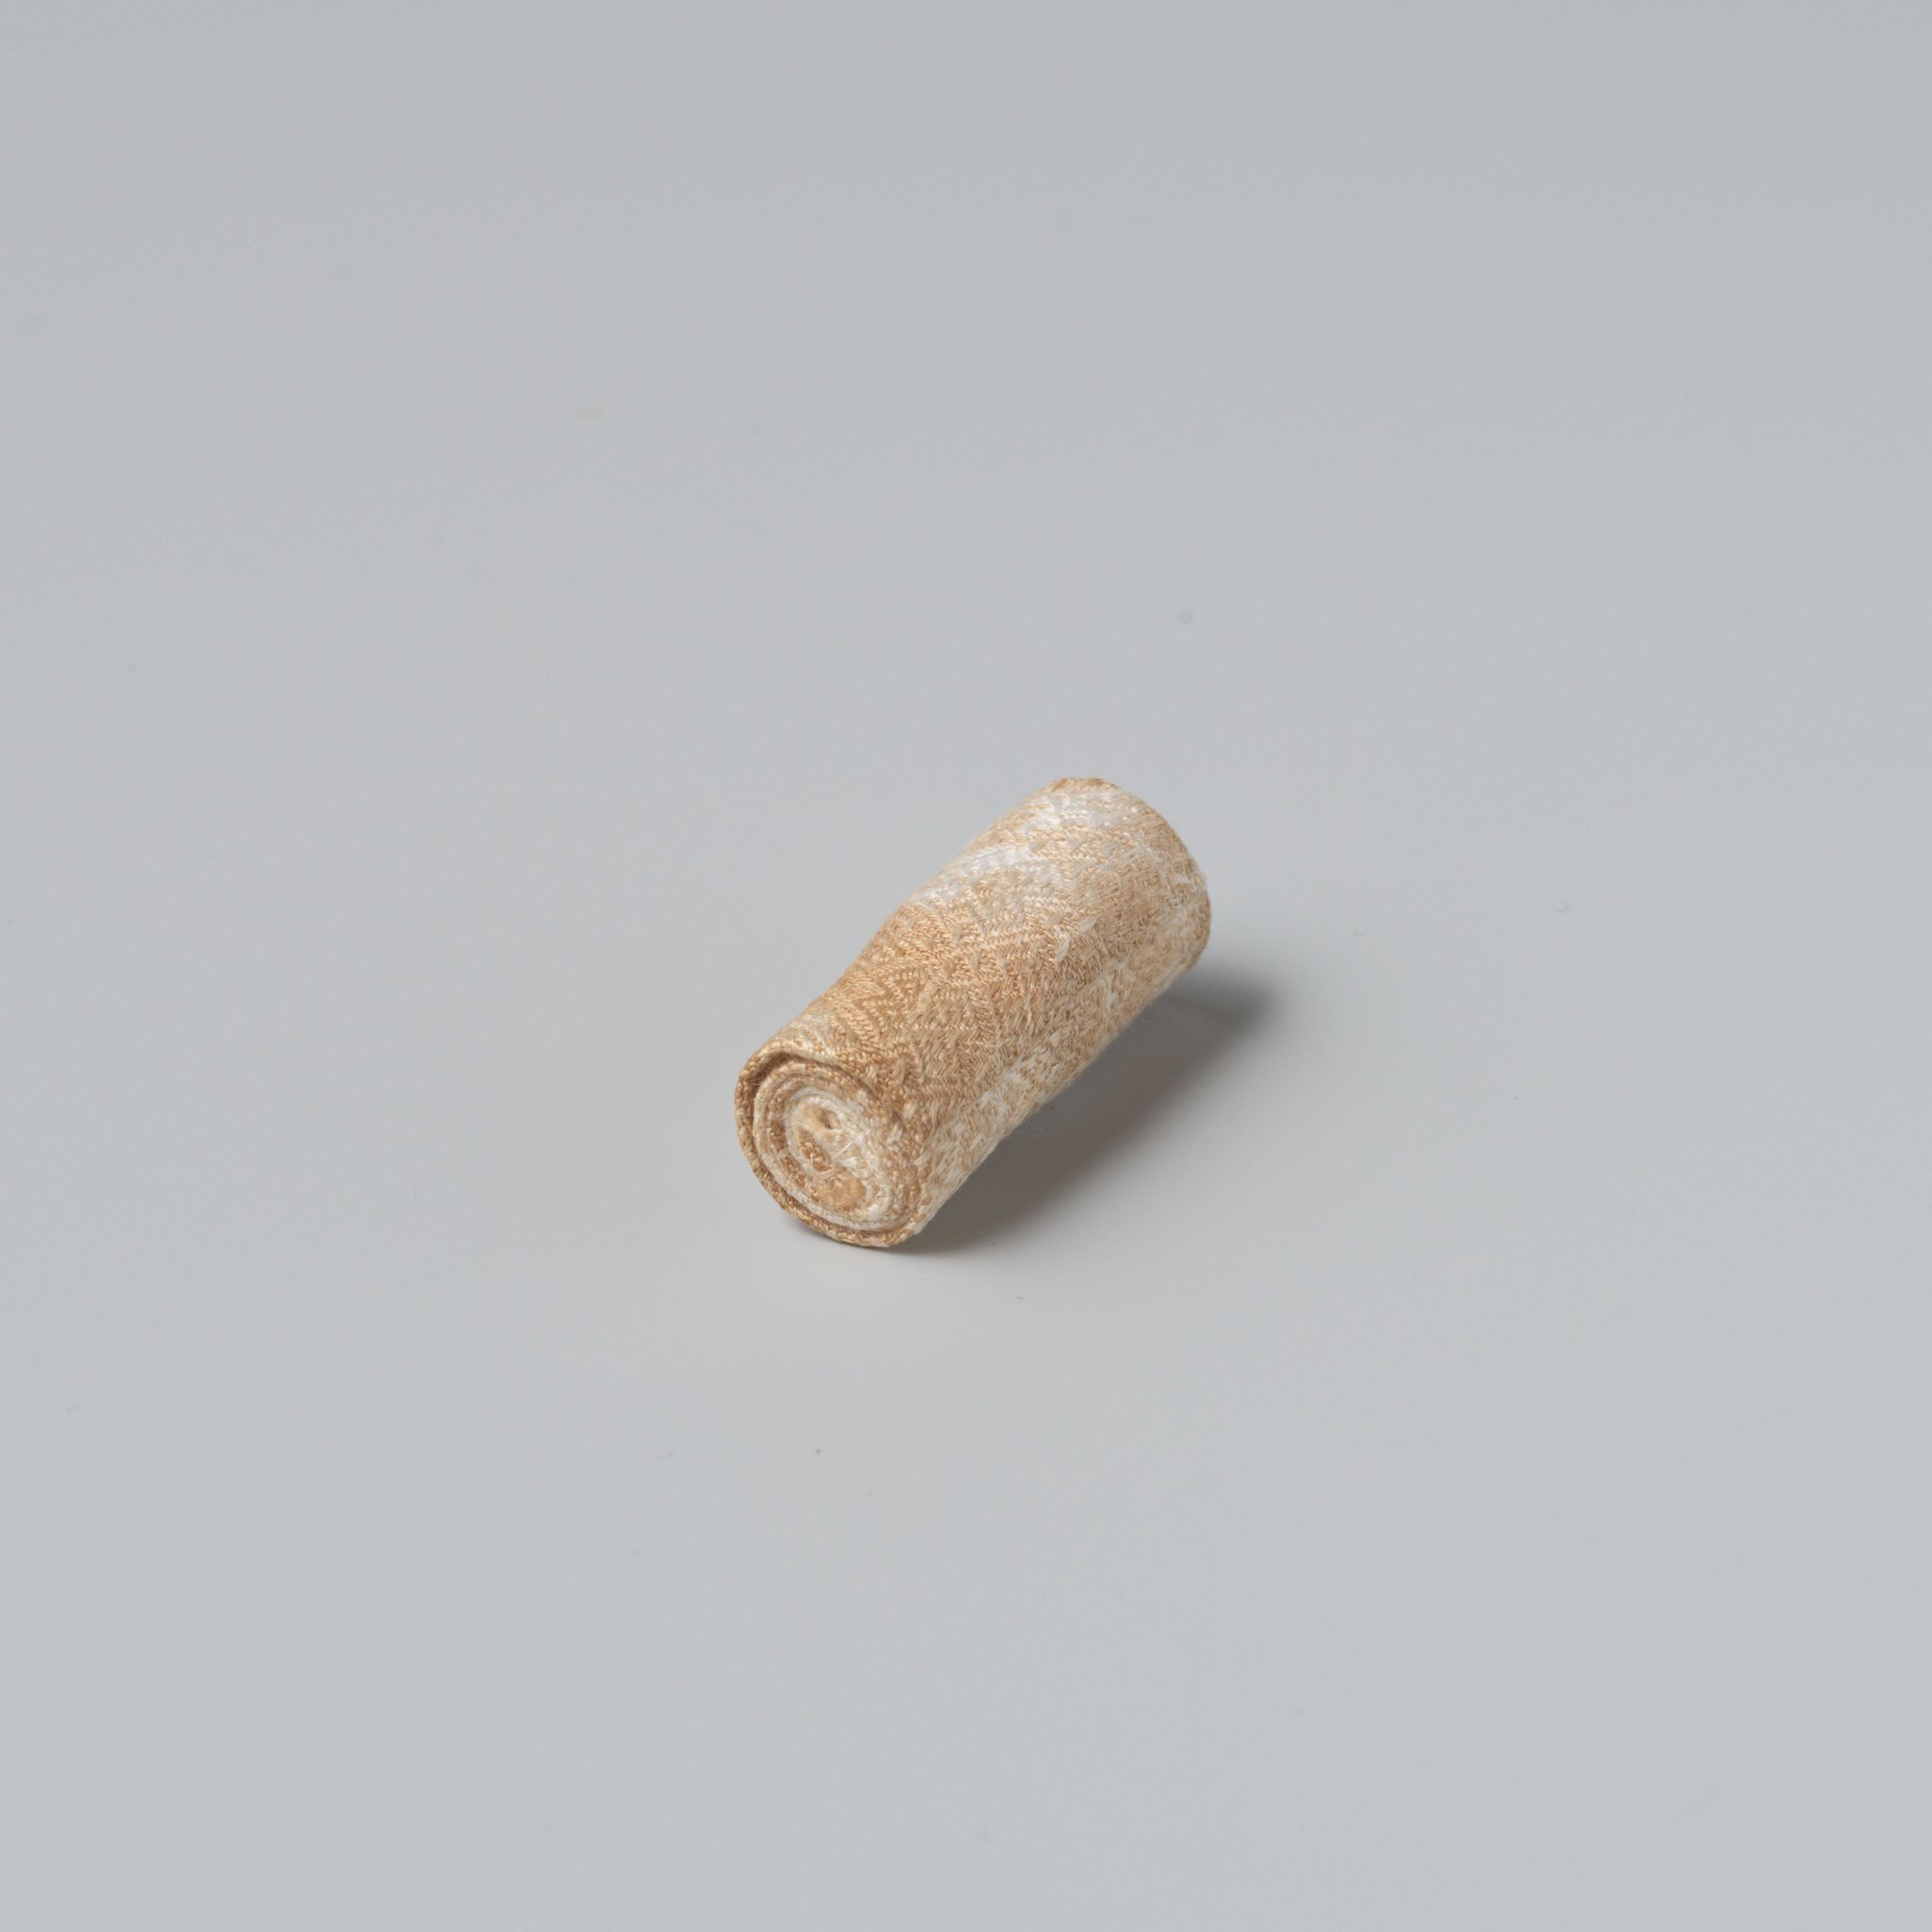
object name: miniature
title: Rol linnen, damastweefsel met pellenpatroon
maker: Anonymous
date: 1600-1699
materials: linen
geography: netherlands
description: Rol linnen, damastweefsel met pellenpatroon.